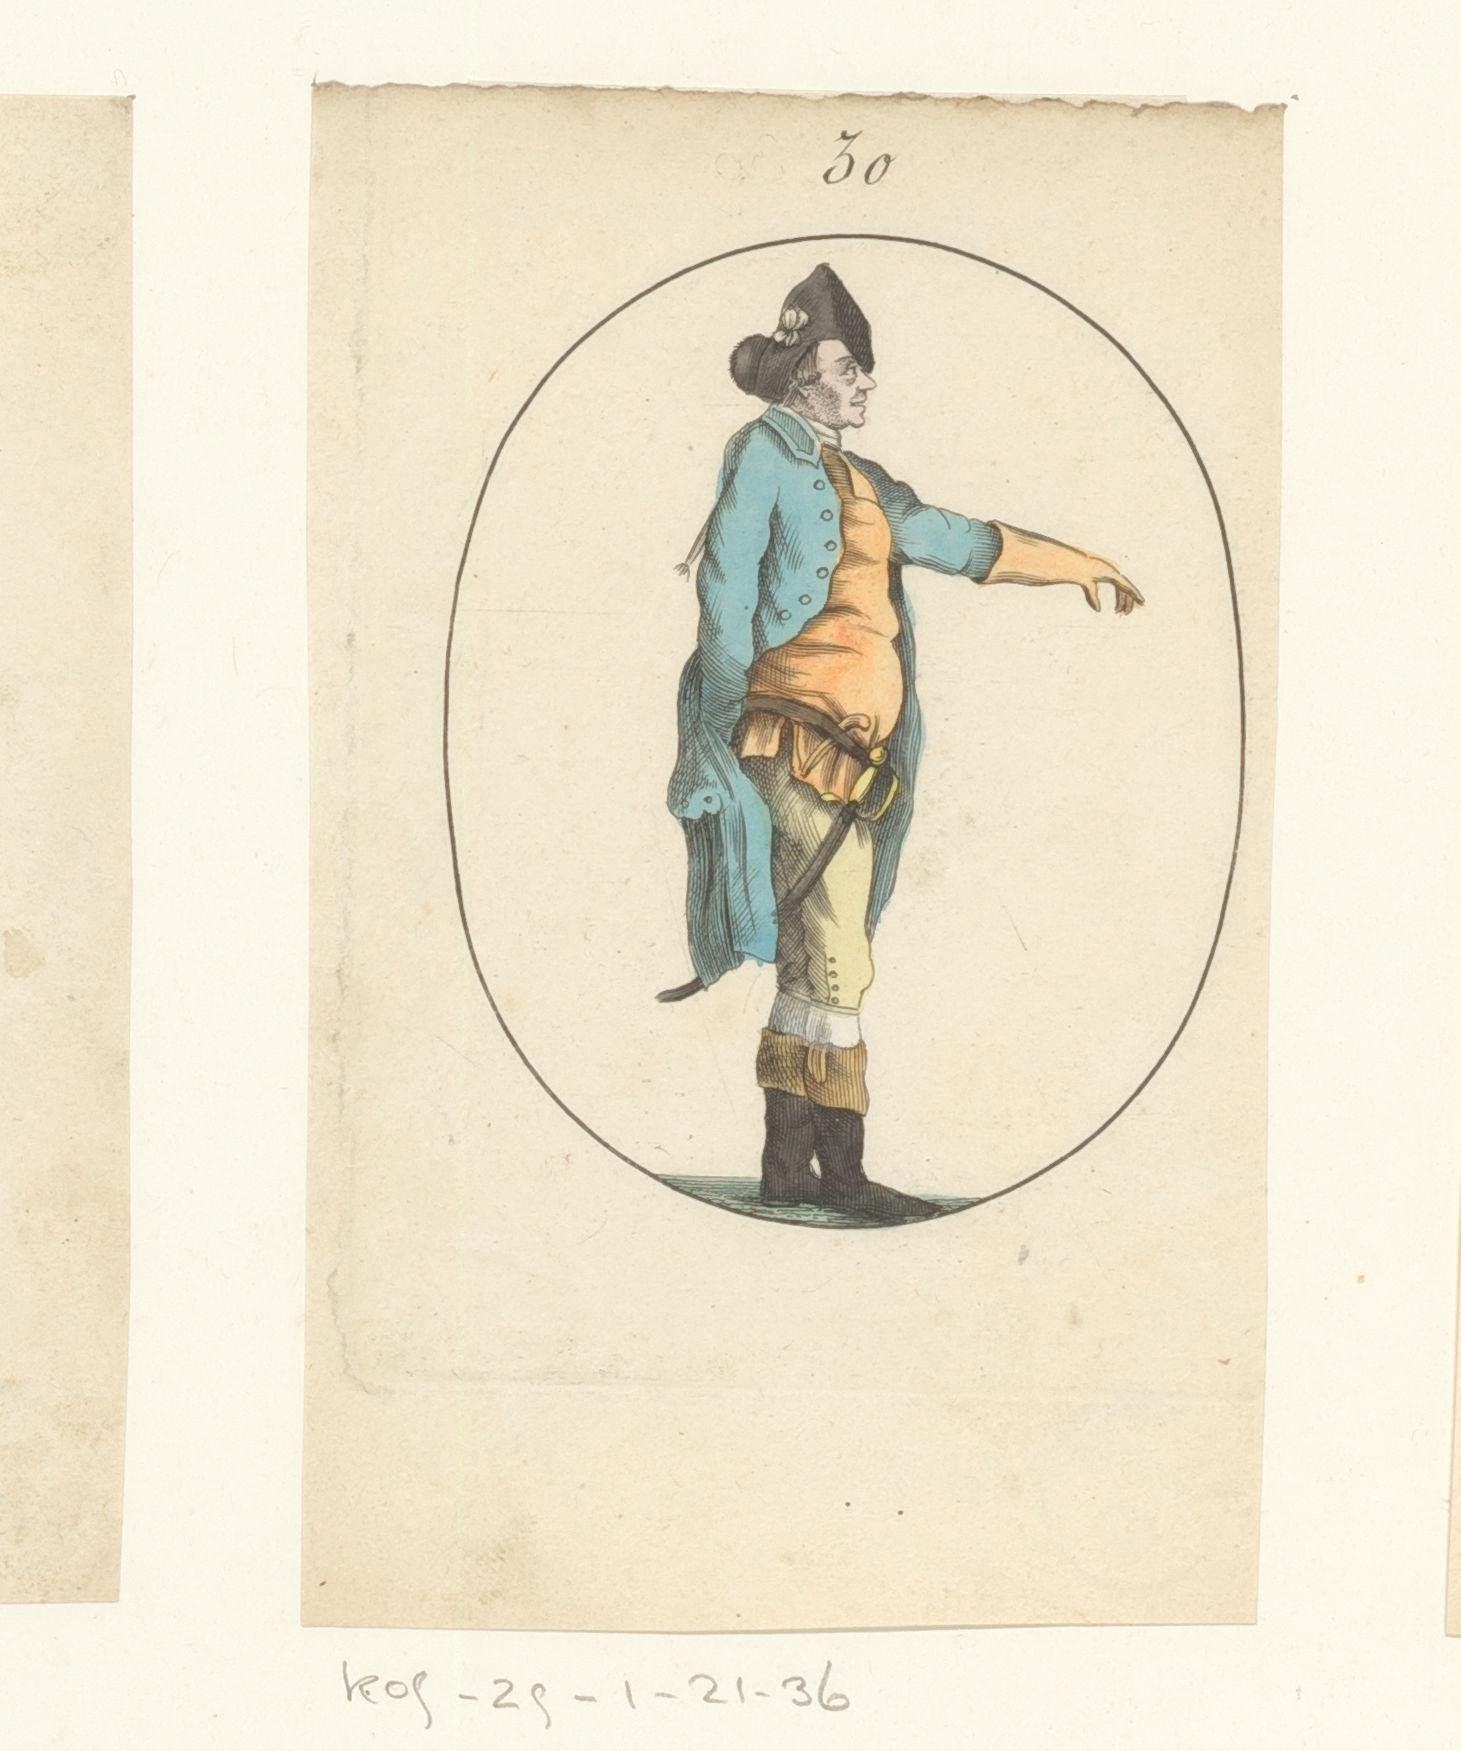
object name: print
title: Staande man met uitgestrekte hand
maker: Anonymous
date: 1750-1849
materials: paper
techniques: etching, hand coloring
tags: head-gear: bicorne, bicorn, standing figure, running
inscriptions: collector's mark: Lugt 1641a, stamp, collector's mark: Lugt 1641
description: Bovenaan genummerd: 30. Onderwerpsrubrieken binnen de Atlas Zeden en Gewoonten: Zeden en Gewoonten in Engeren Zin, De Kleeding, Kleederdrachten (tijdvakken), De 18de eeuw (de pruikentijd). Mannen en vrouwen.